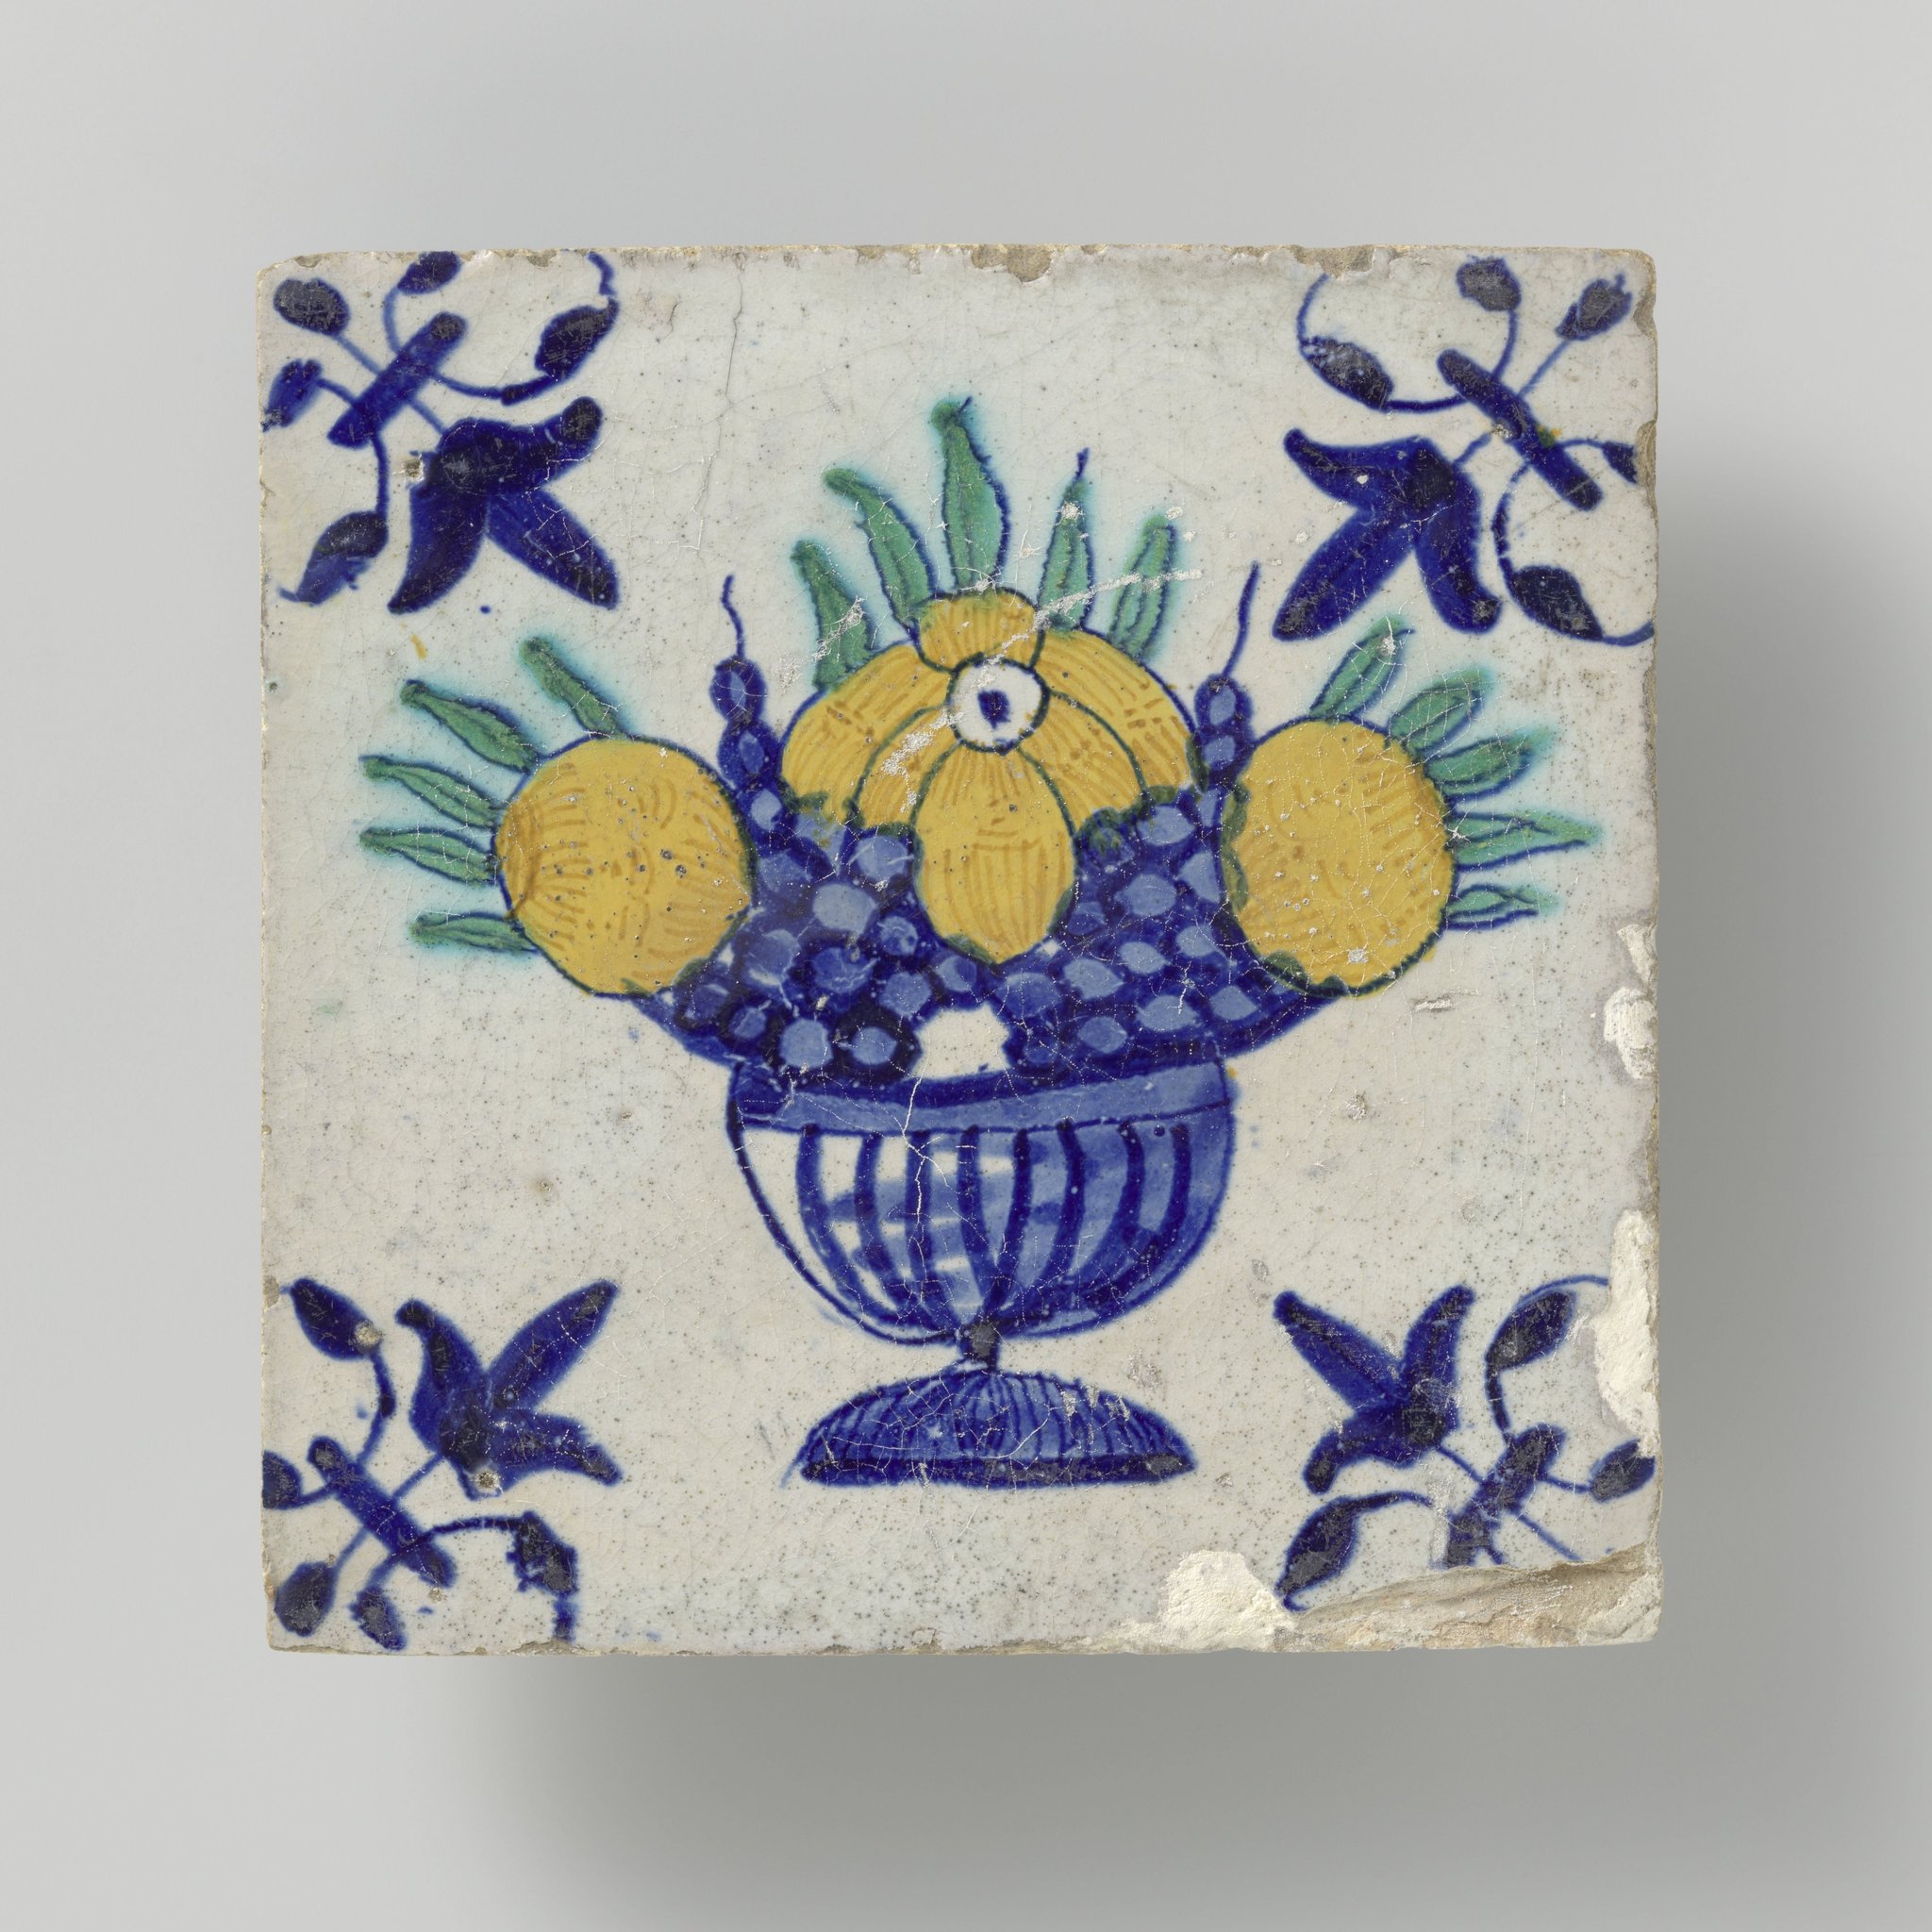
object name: tile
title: Tegel met fruitmand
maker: Anonymous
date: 1640-1660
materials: earthenware, glaze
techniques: maiolica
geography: netherlands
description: Tegel met een veelkleurige (blauw, groen, oranje en geel) fruitmand. In de hoeken, een lelie.